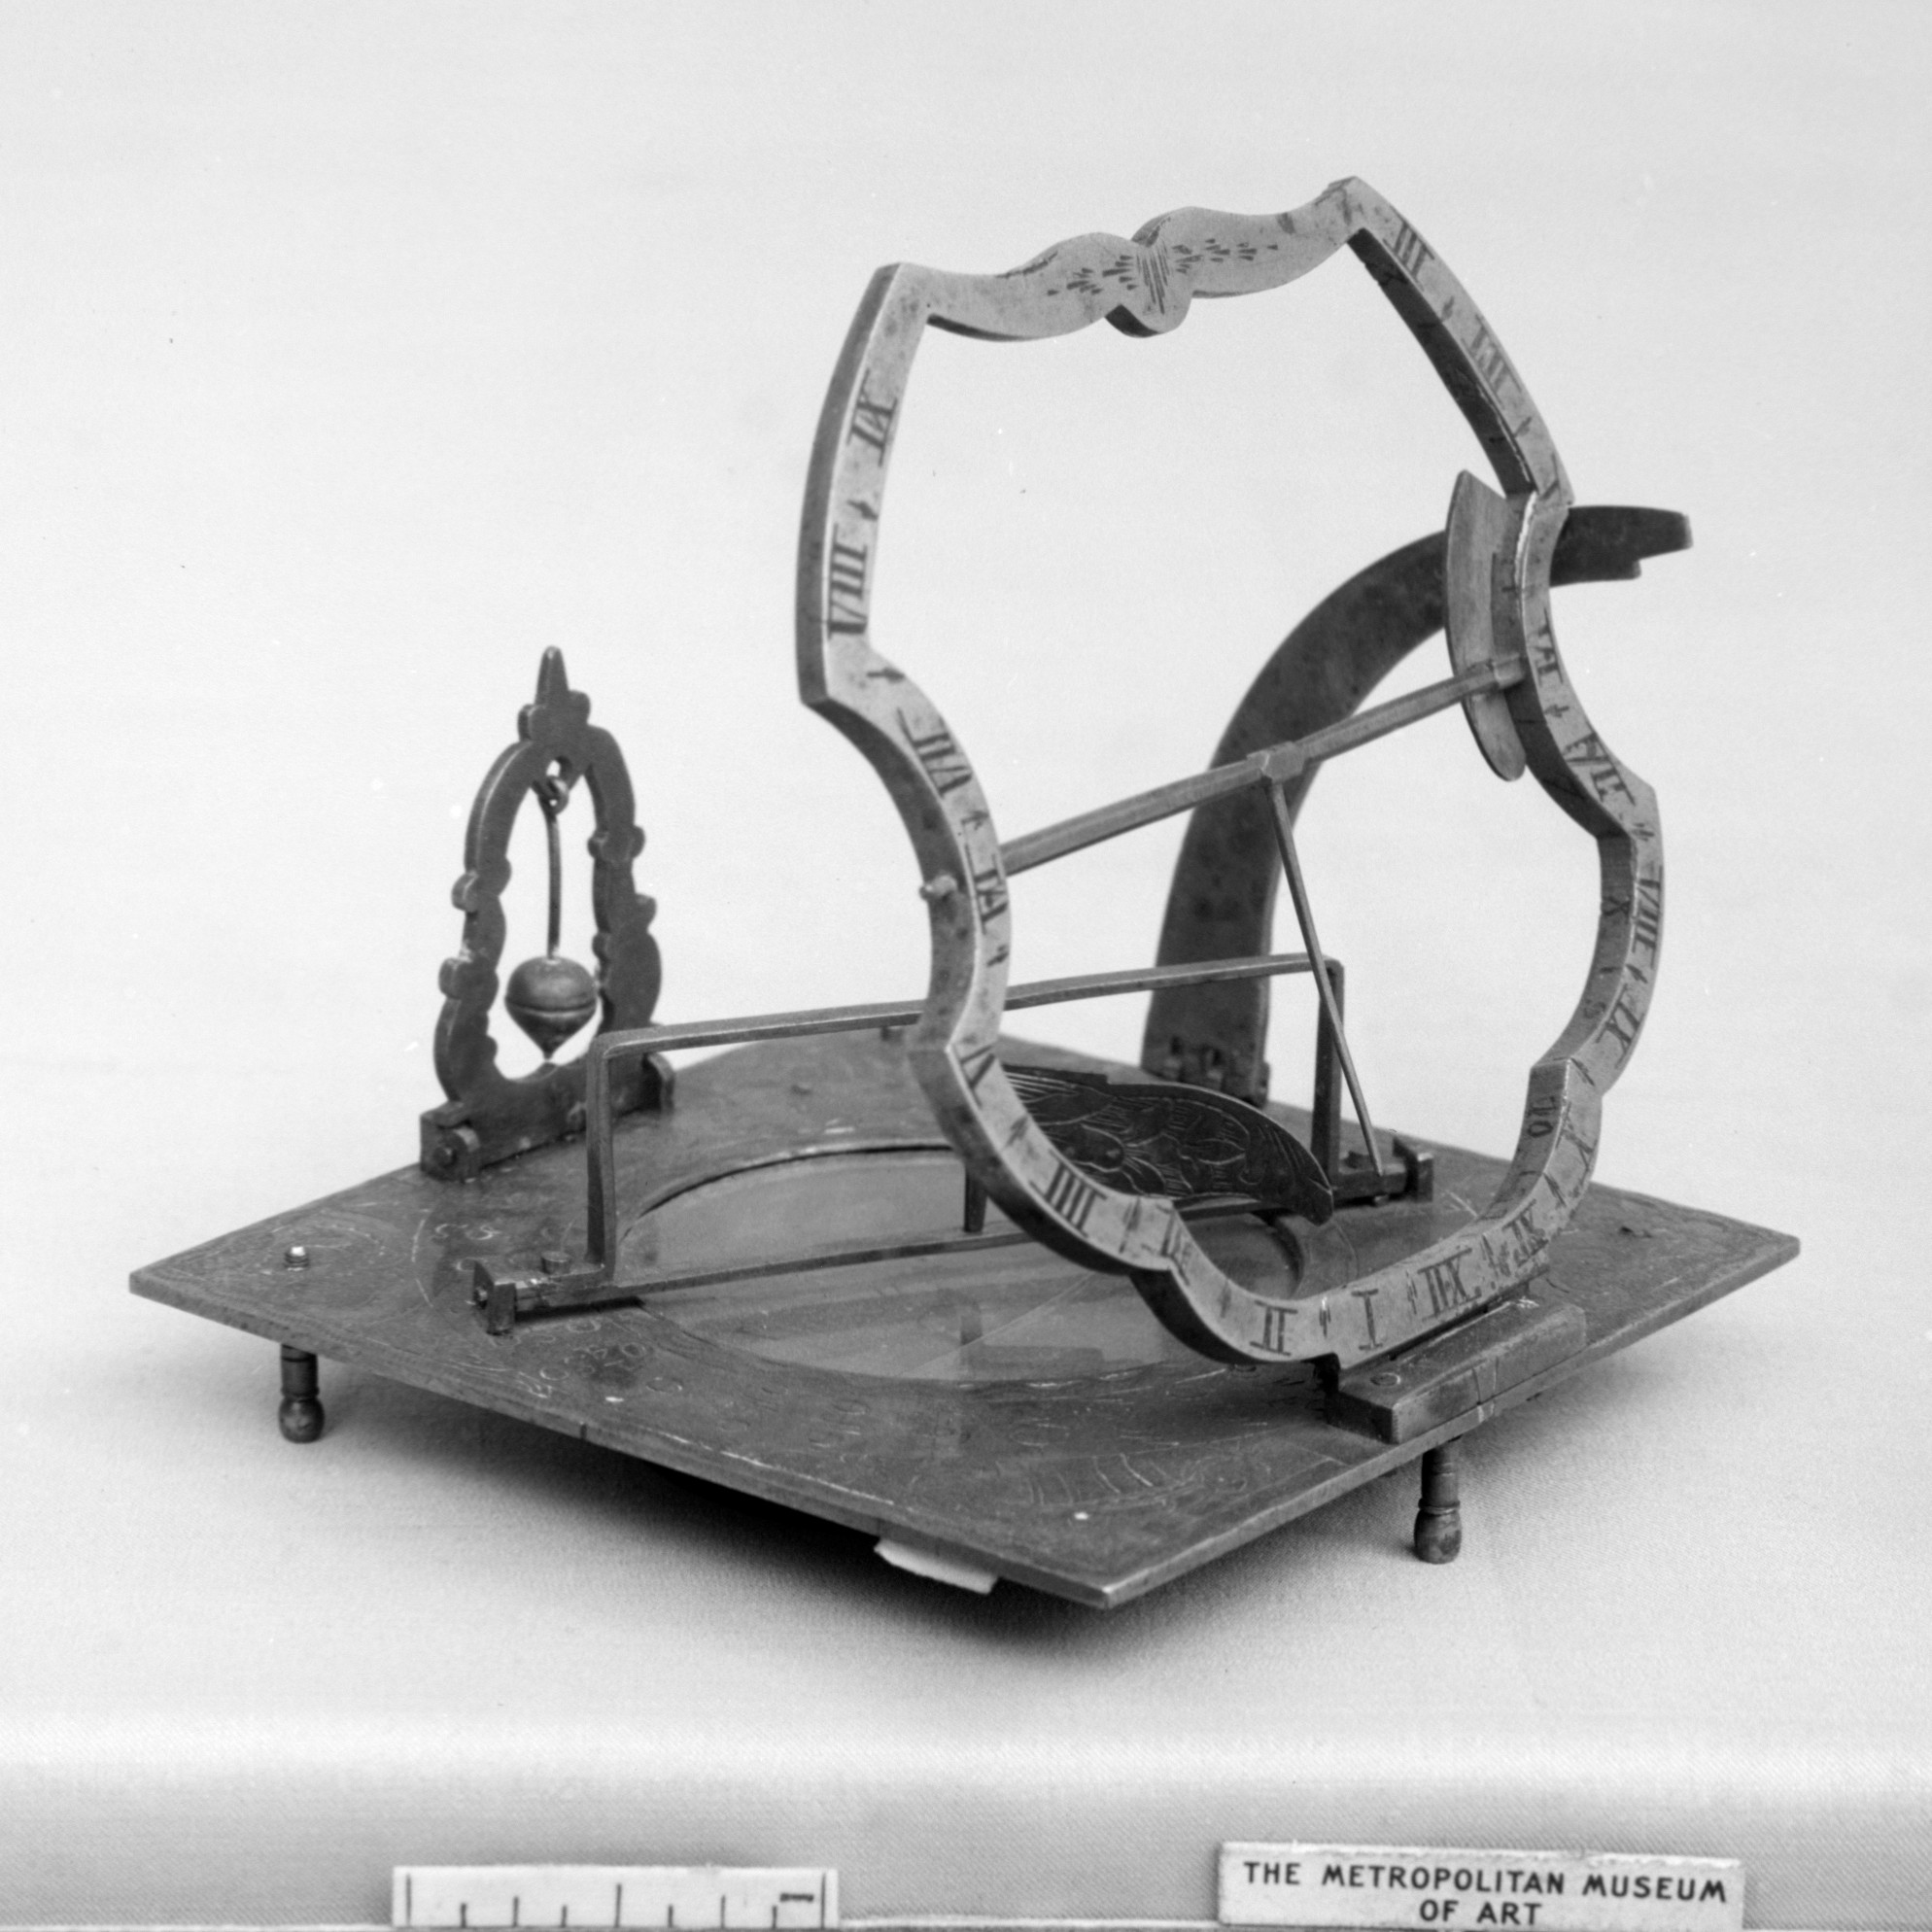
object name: portable equatorial sundial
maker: lorenz gräsl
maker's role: maker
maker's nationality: german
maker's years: 1740-1805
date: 1772-1790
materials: brass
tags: sundials